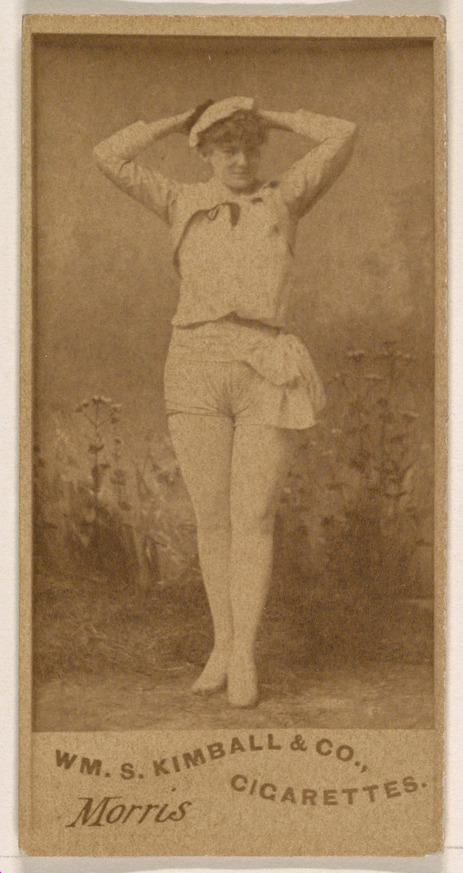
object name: photograph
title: Miss Morris, from the Actresses series (N203) issued by Wm. S. Kimball & Co.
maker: william s. kimball & company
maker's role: publisher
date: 1889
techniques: color lithograph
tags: portraits,women,actresses